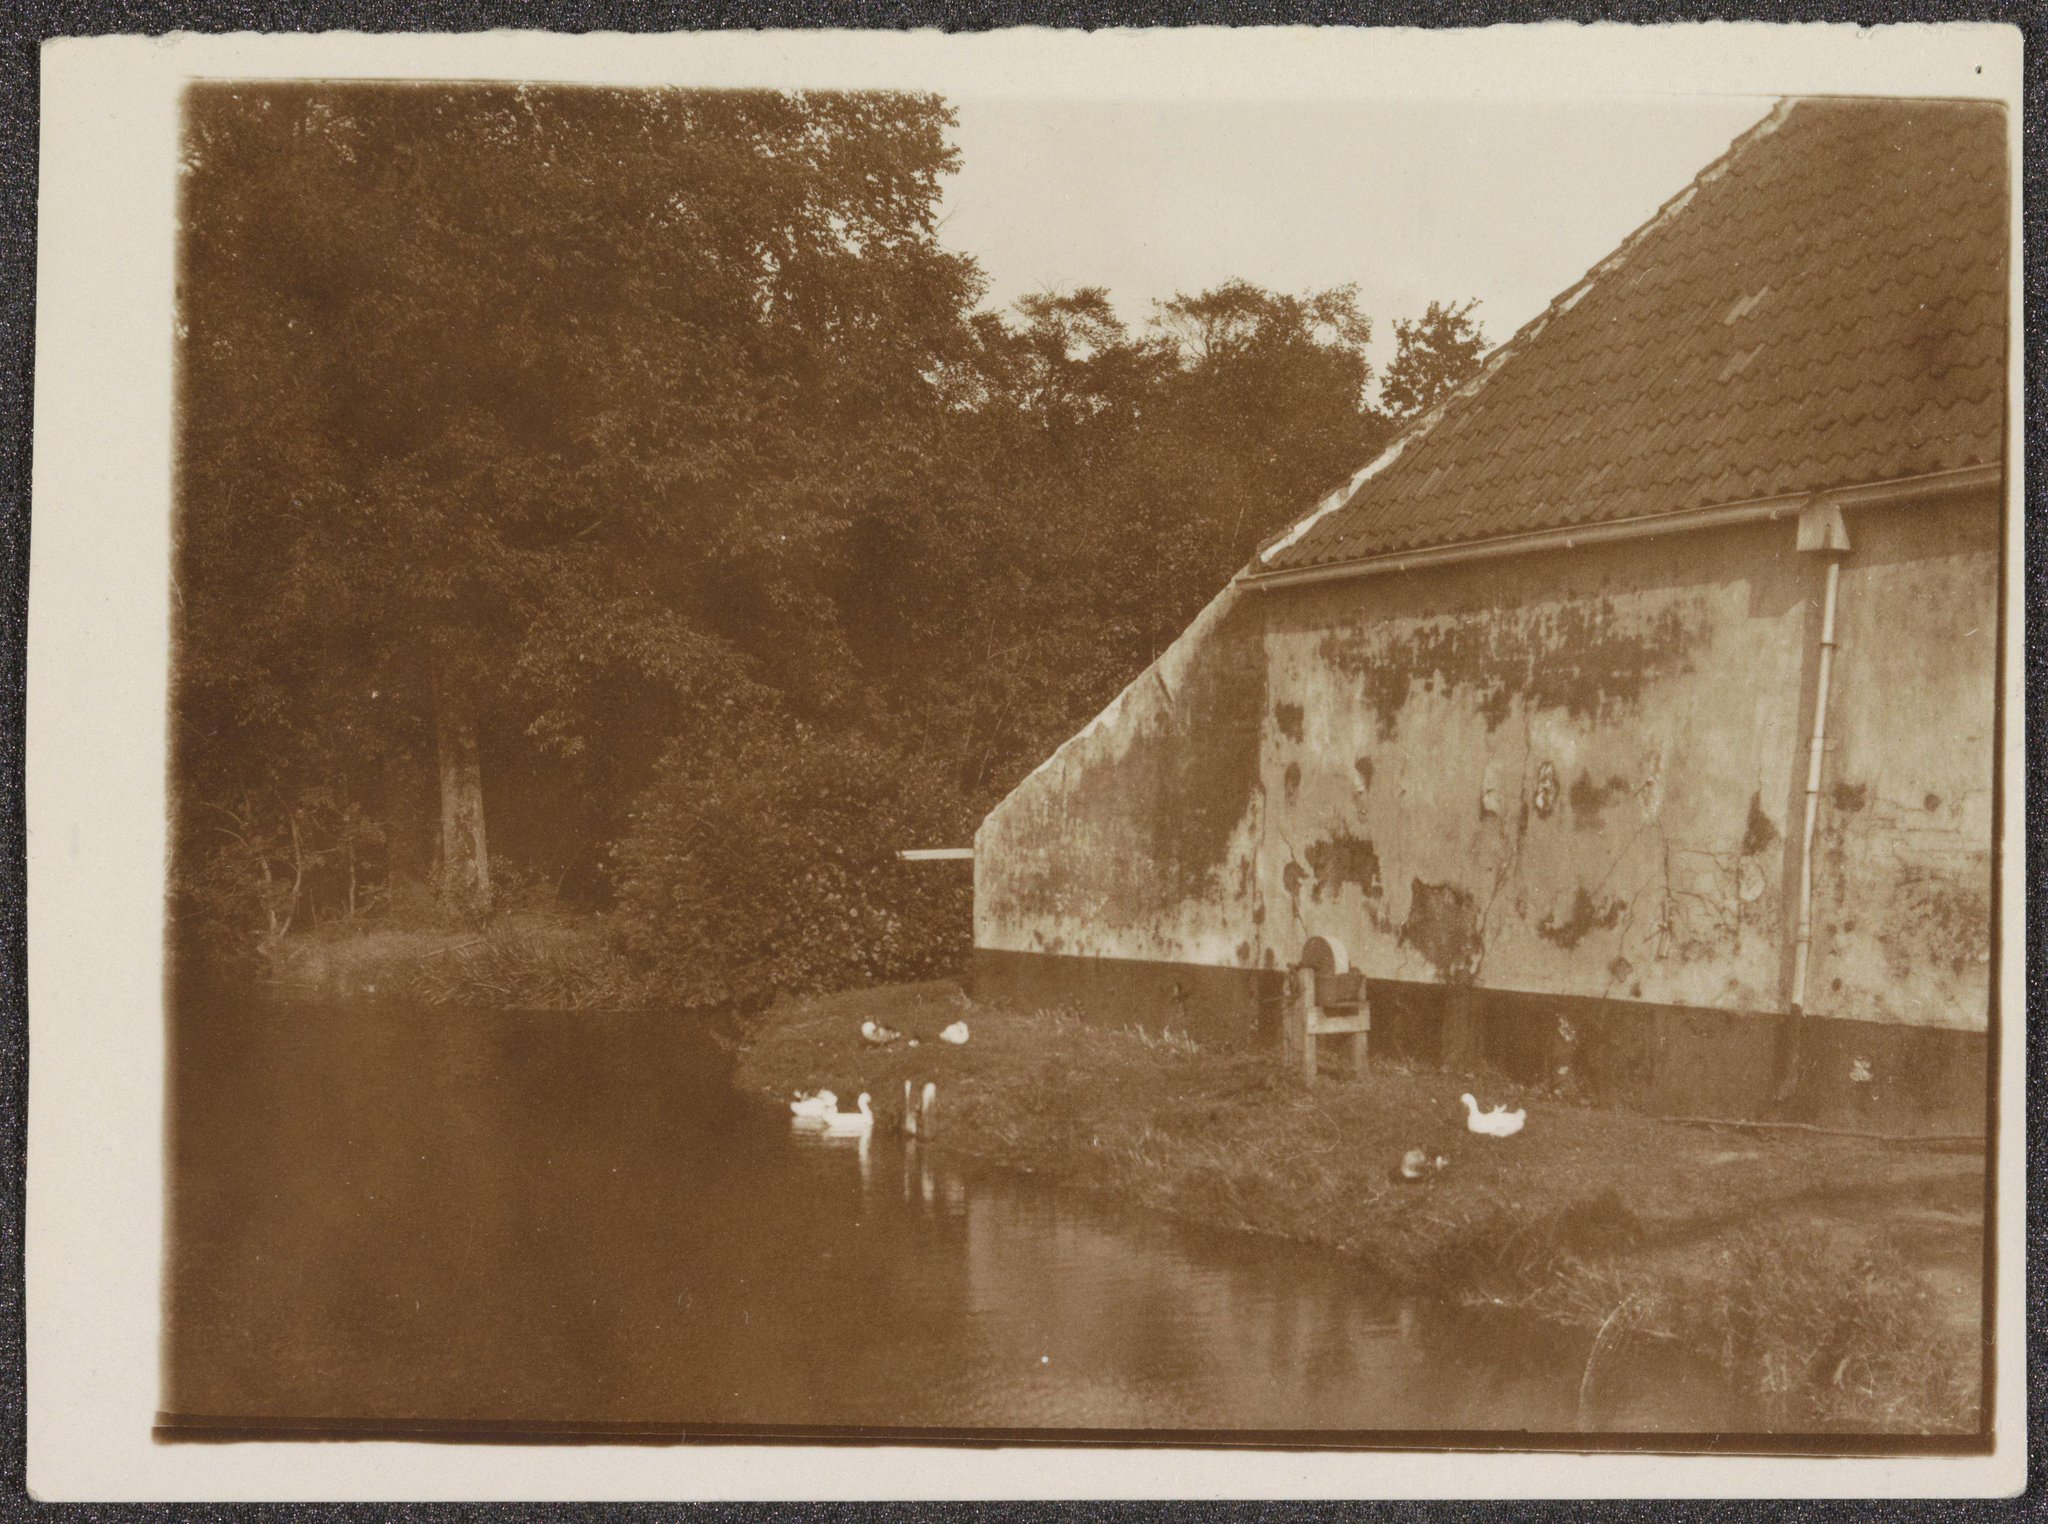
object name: photograph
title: Bij Voorburg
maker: h.c. wilkens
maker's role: amateurfotograaf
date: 1915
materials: photographic support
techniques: gelatin silver print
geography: voorburg